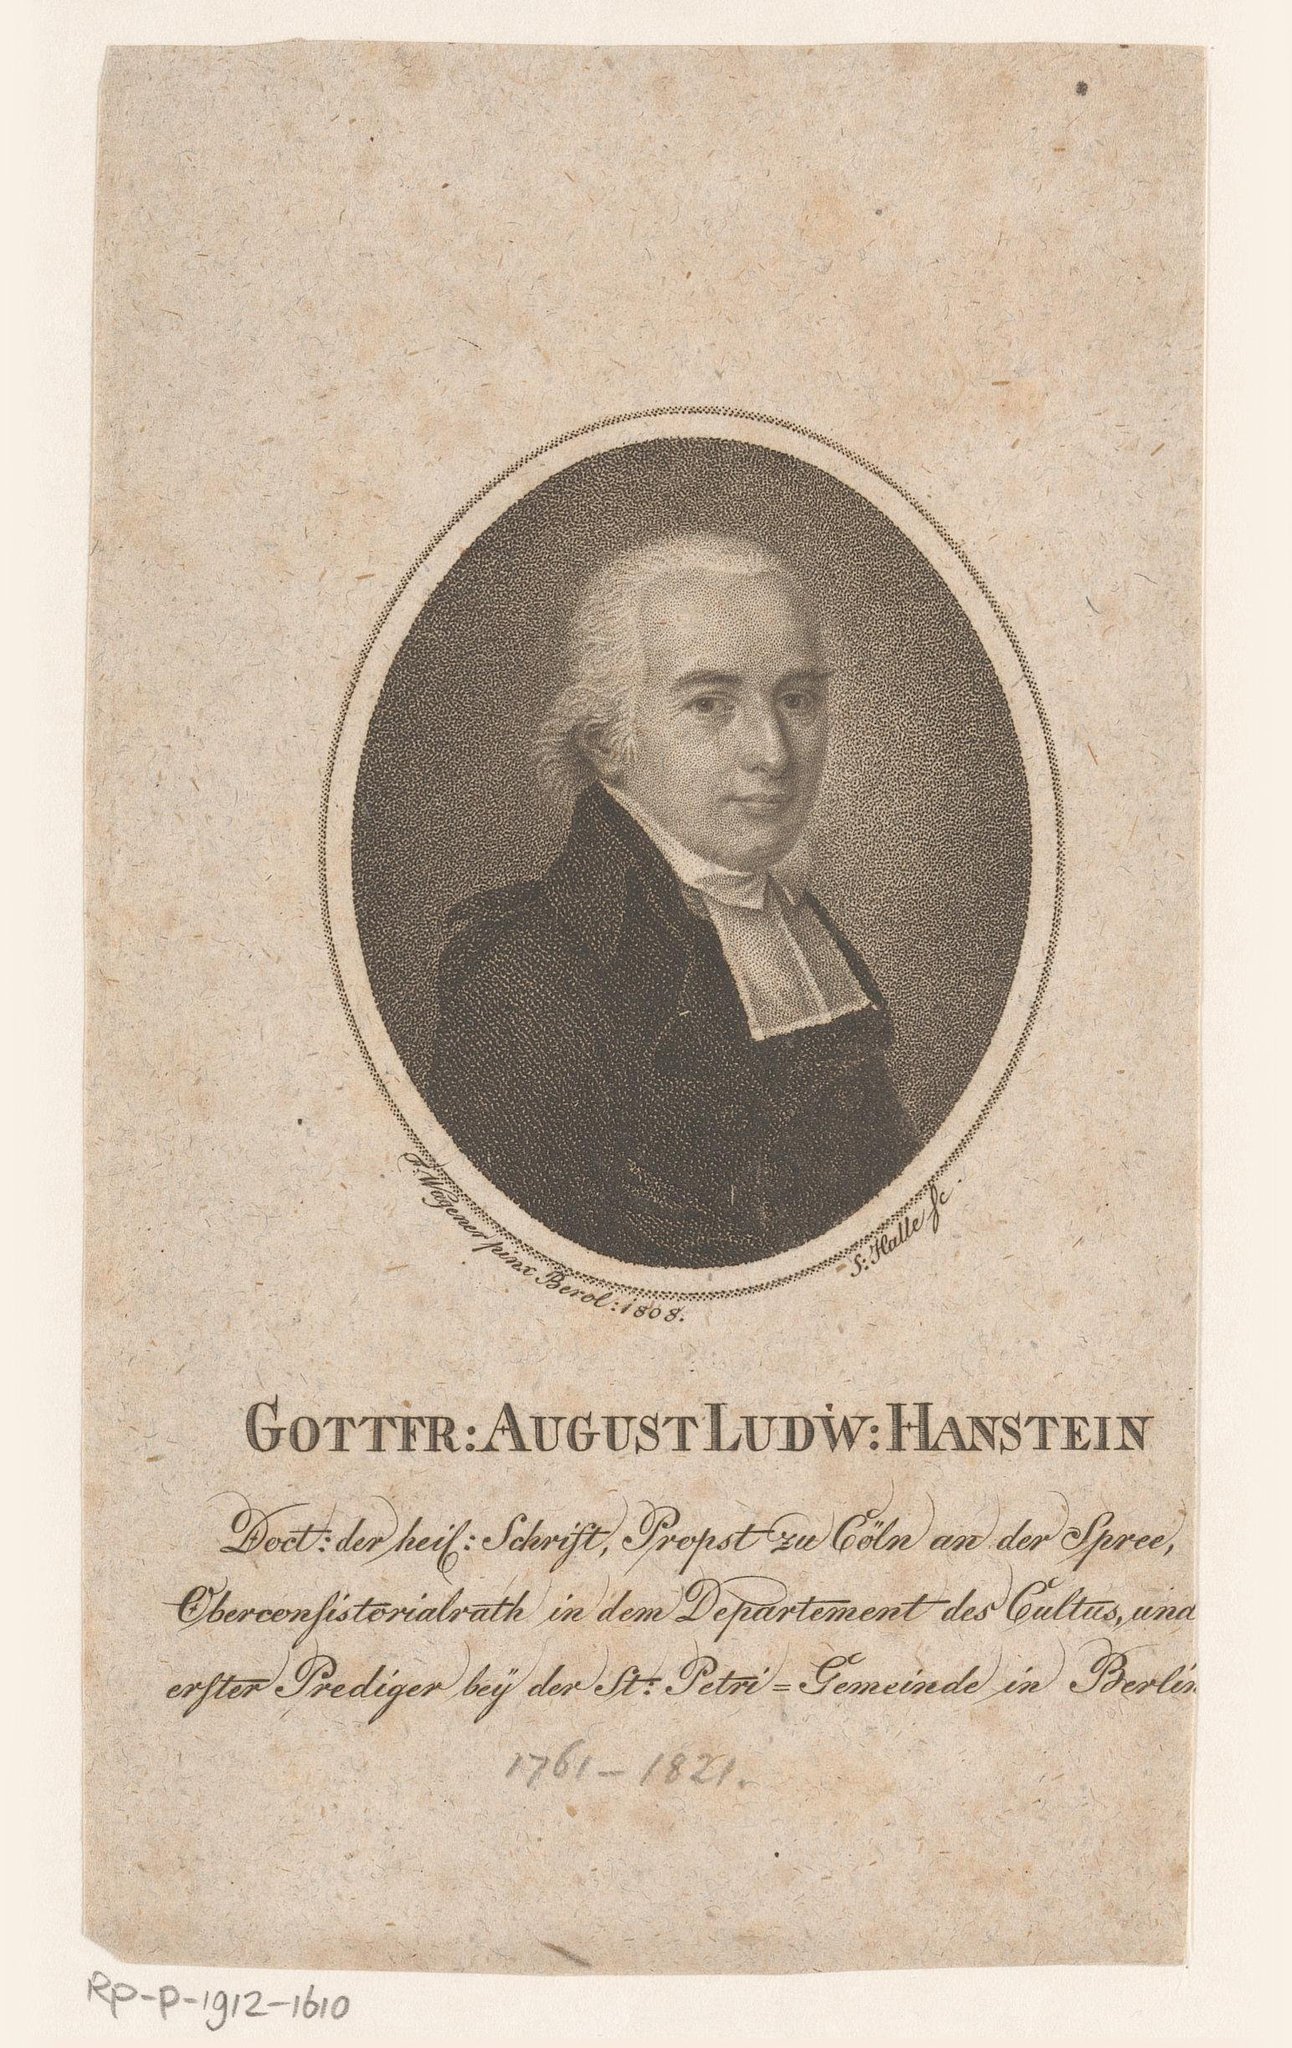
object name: print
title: Portret van Gottfried August Ludwig Hanstein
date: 1808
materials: paper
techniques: stippling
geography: berlin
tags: berlin, historical persons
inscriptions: collector's mark: Lugt 2228